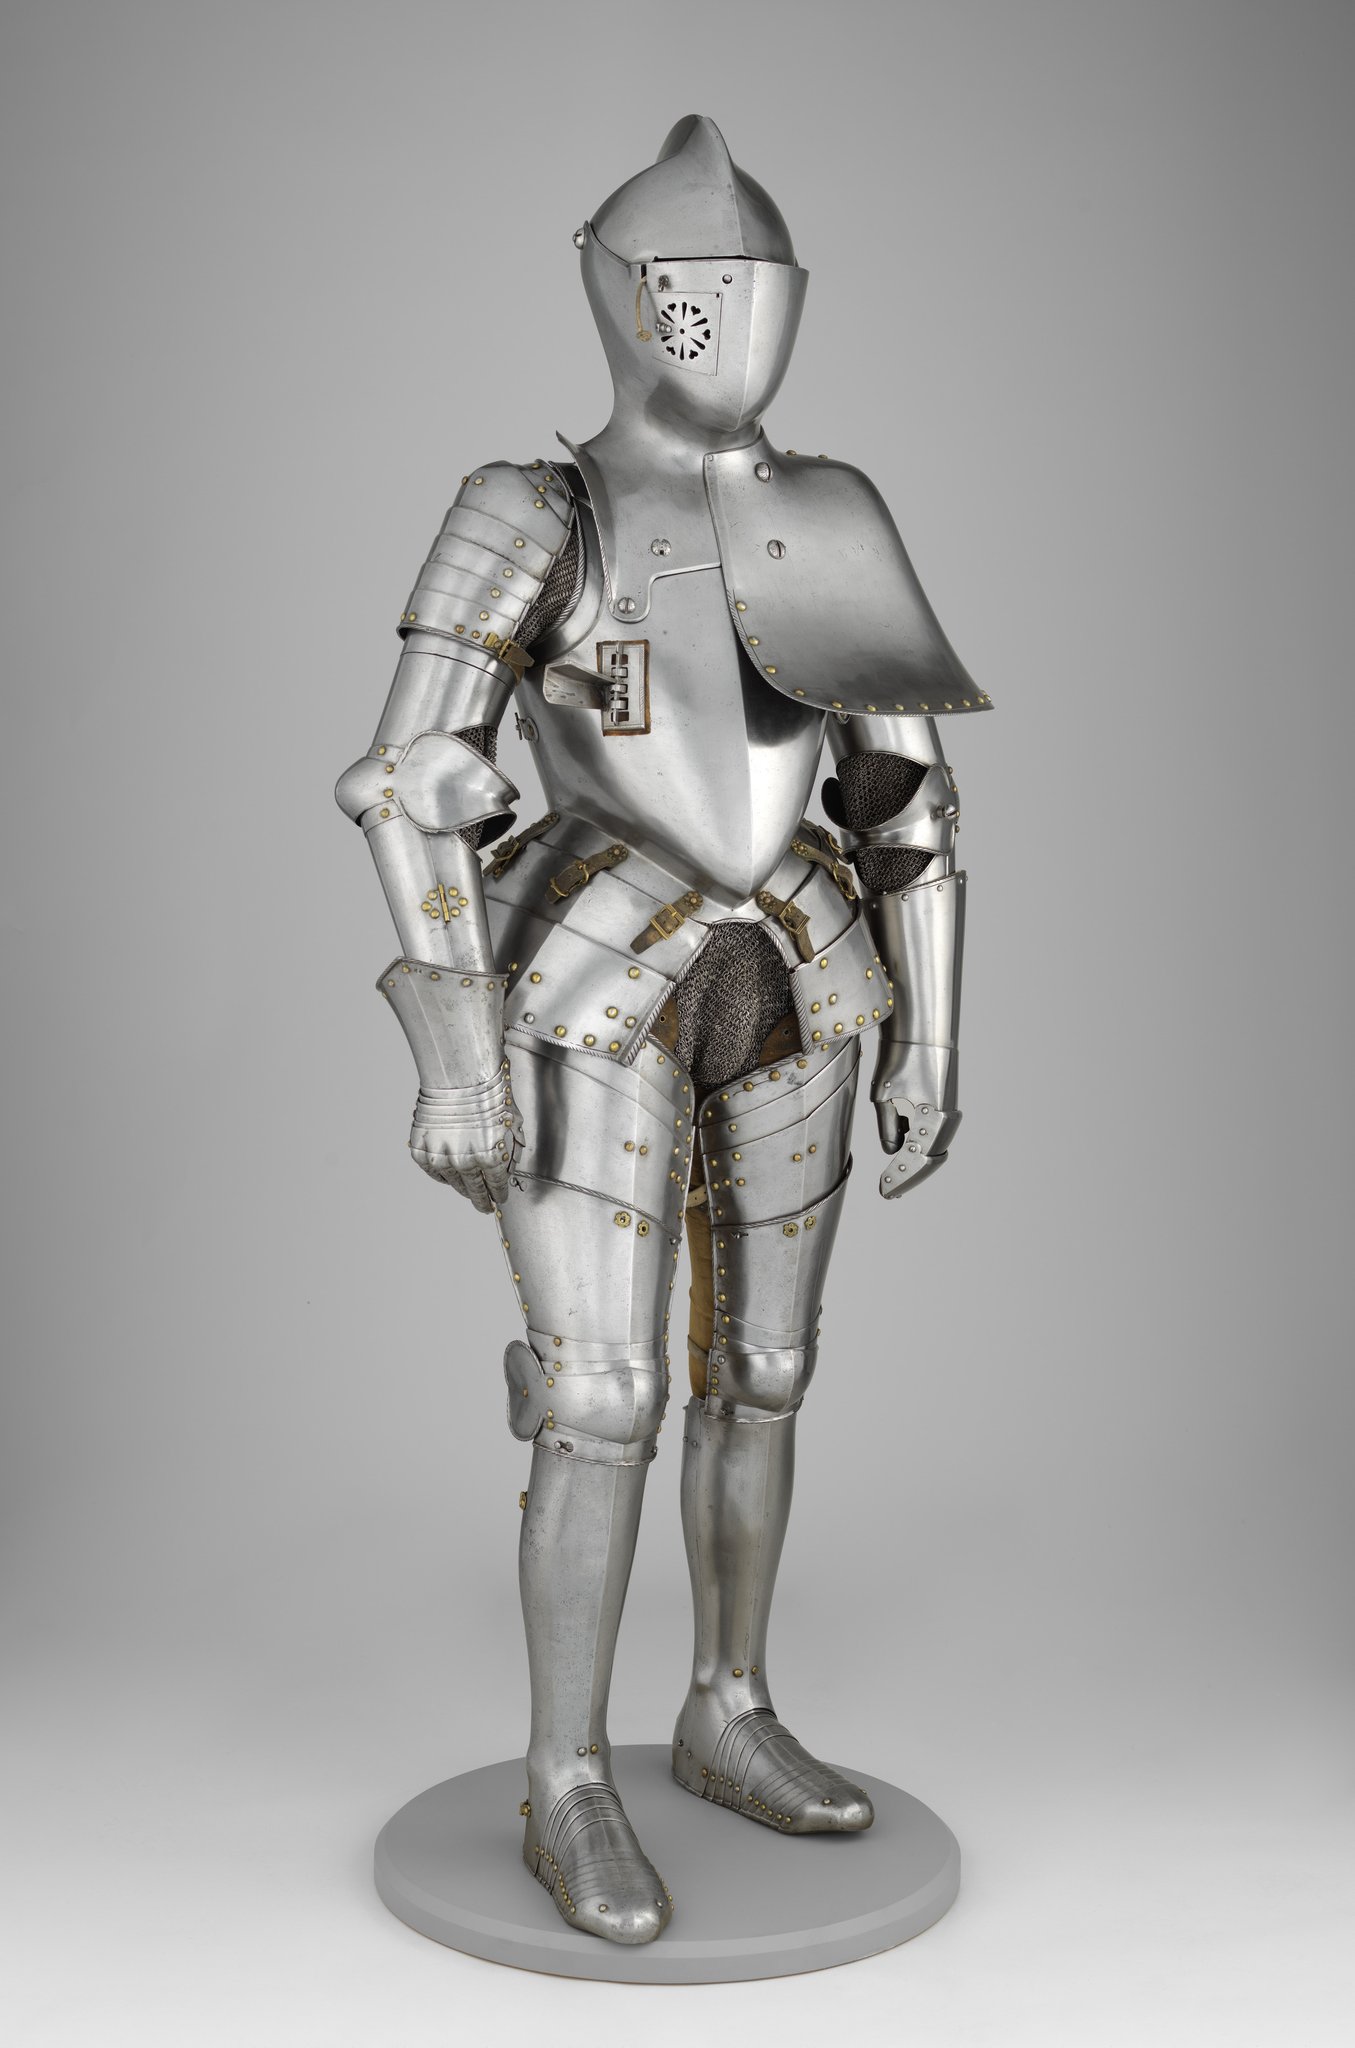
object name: armor for the tilt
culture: german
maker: anton peffenhauser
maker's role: armorer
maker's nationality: german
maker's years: 1525-1603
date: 1580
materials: brass, leather, steel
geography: germany